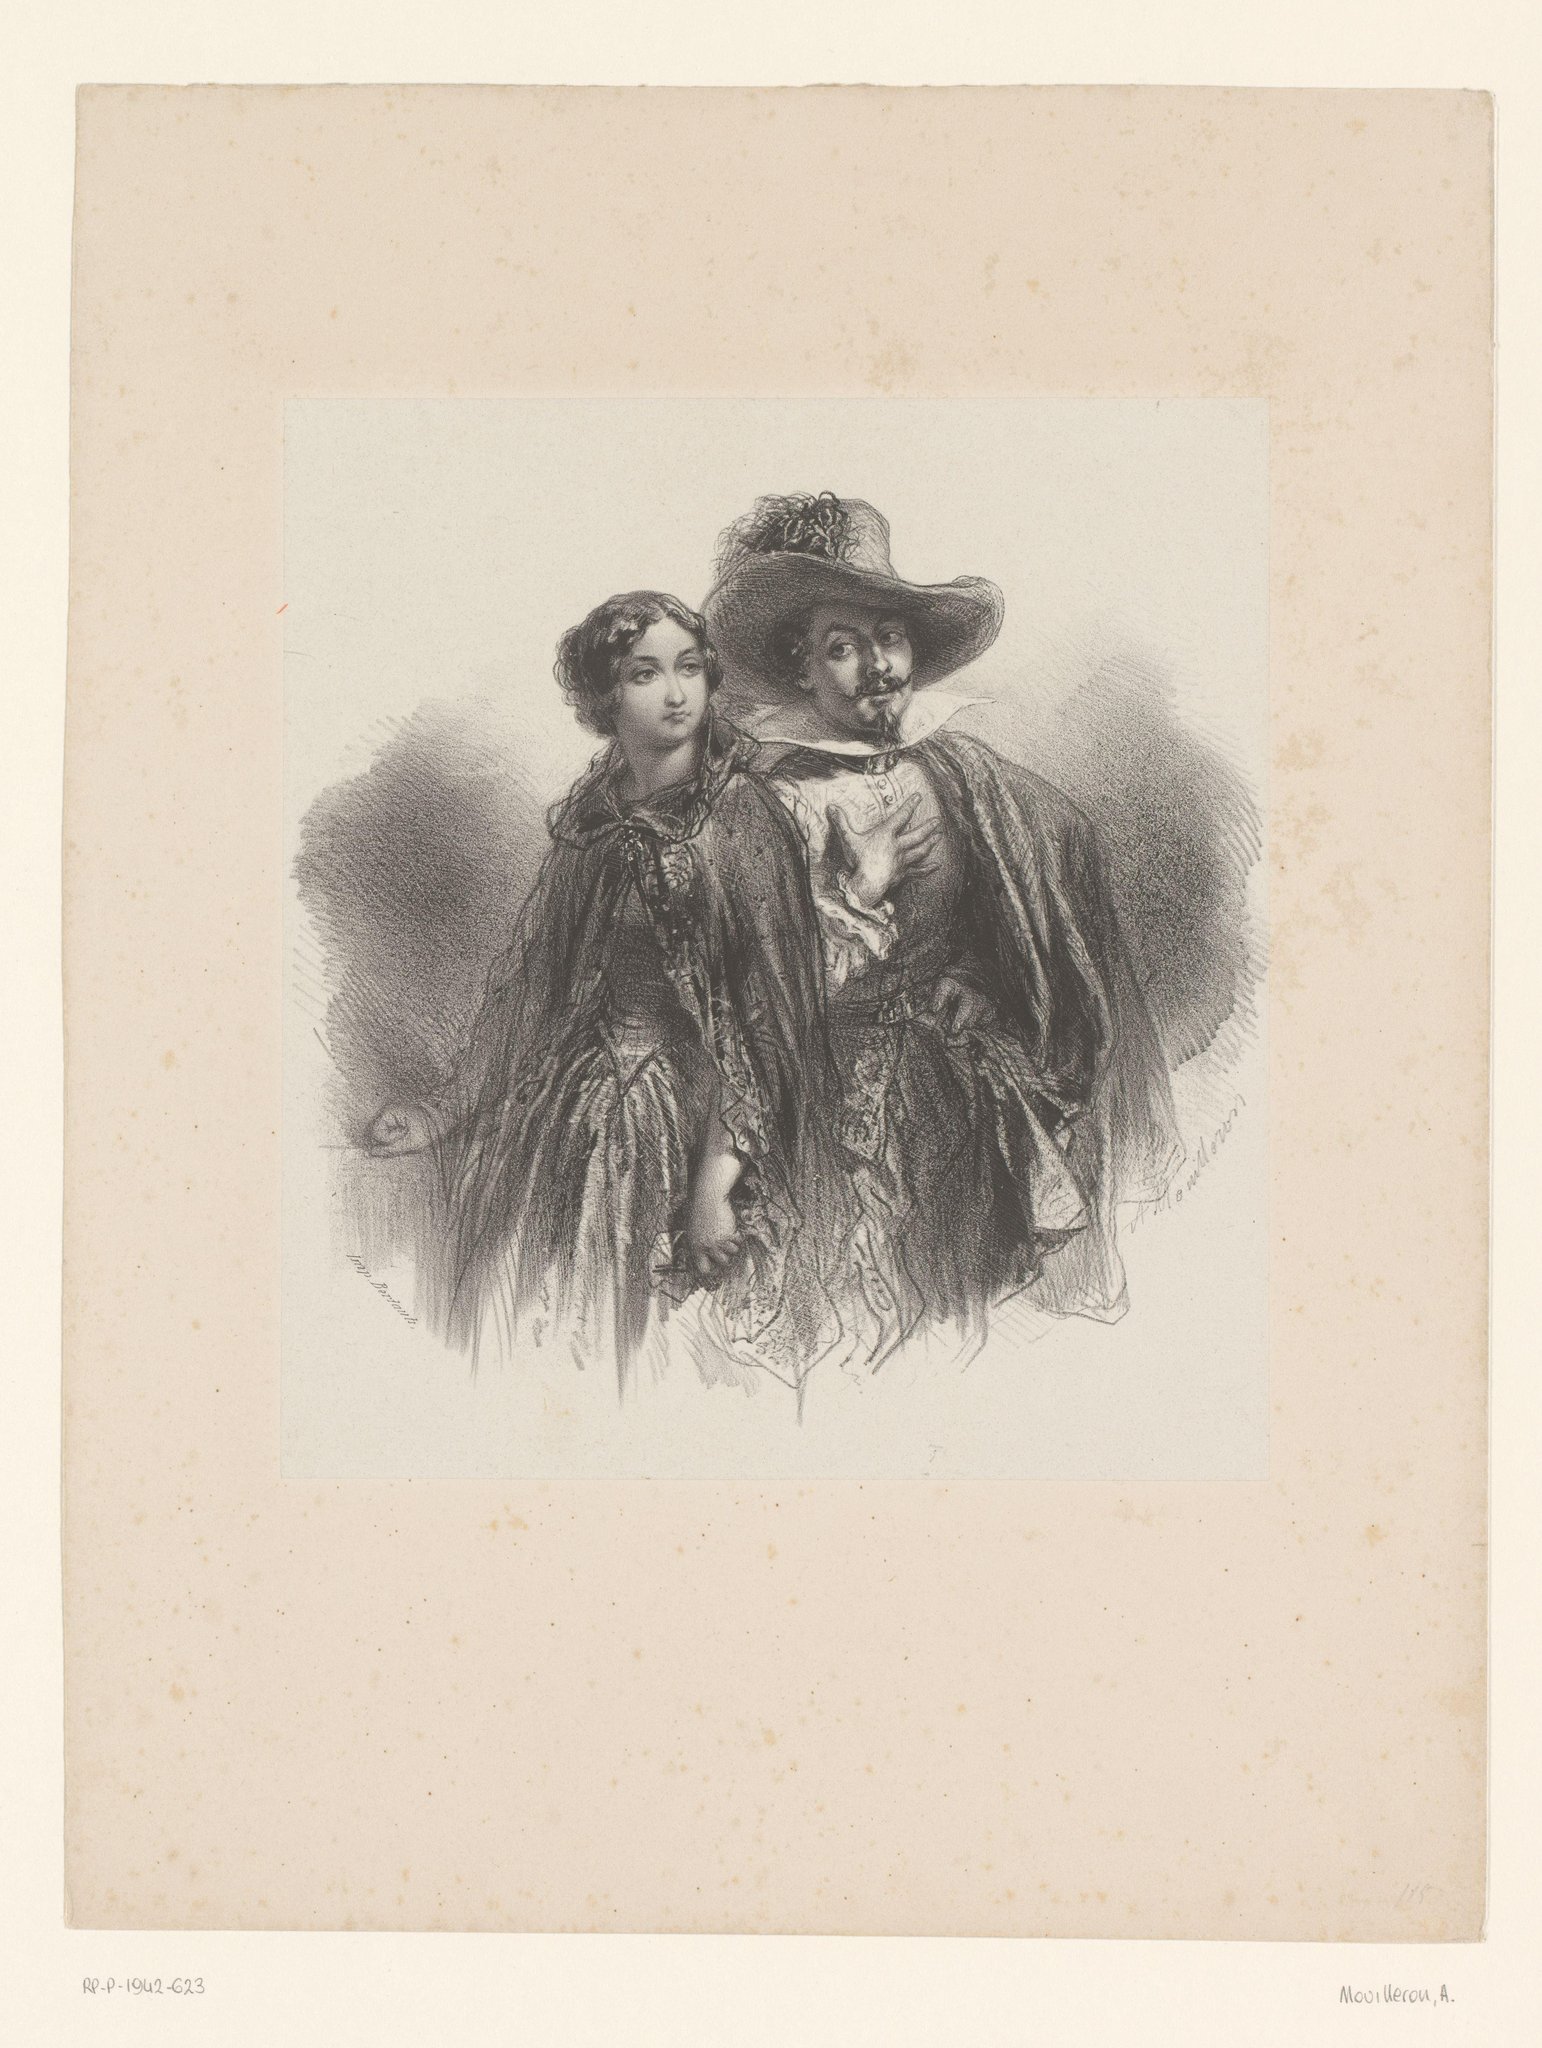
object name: print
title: Man en vrouw in historische kleding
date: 1830-1880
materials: paper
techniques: lithograph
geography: paris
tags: adult woman, adult man, historical costume